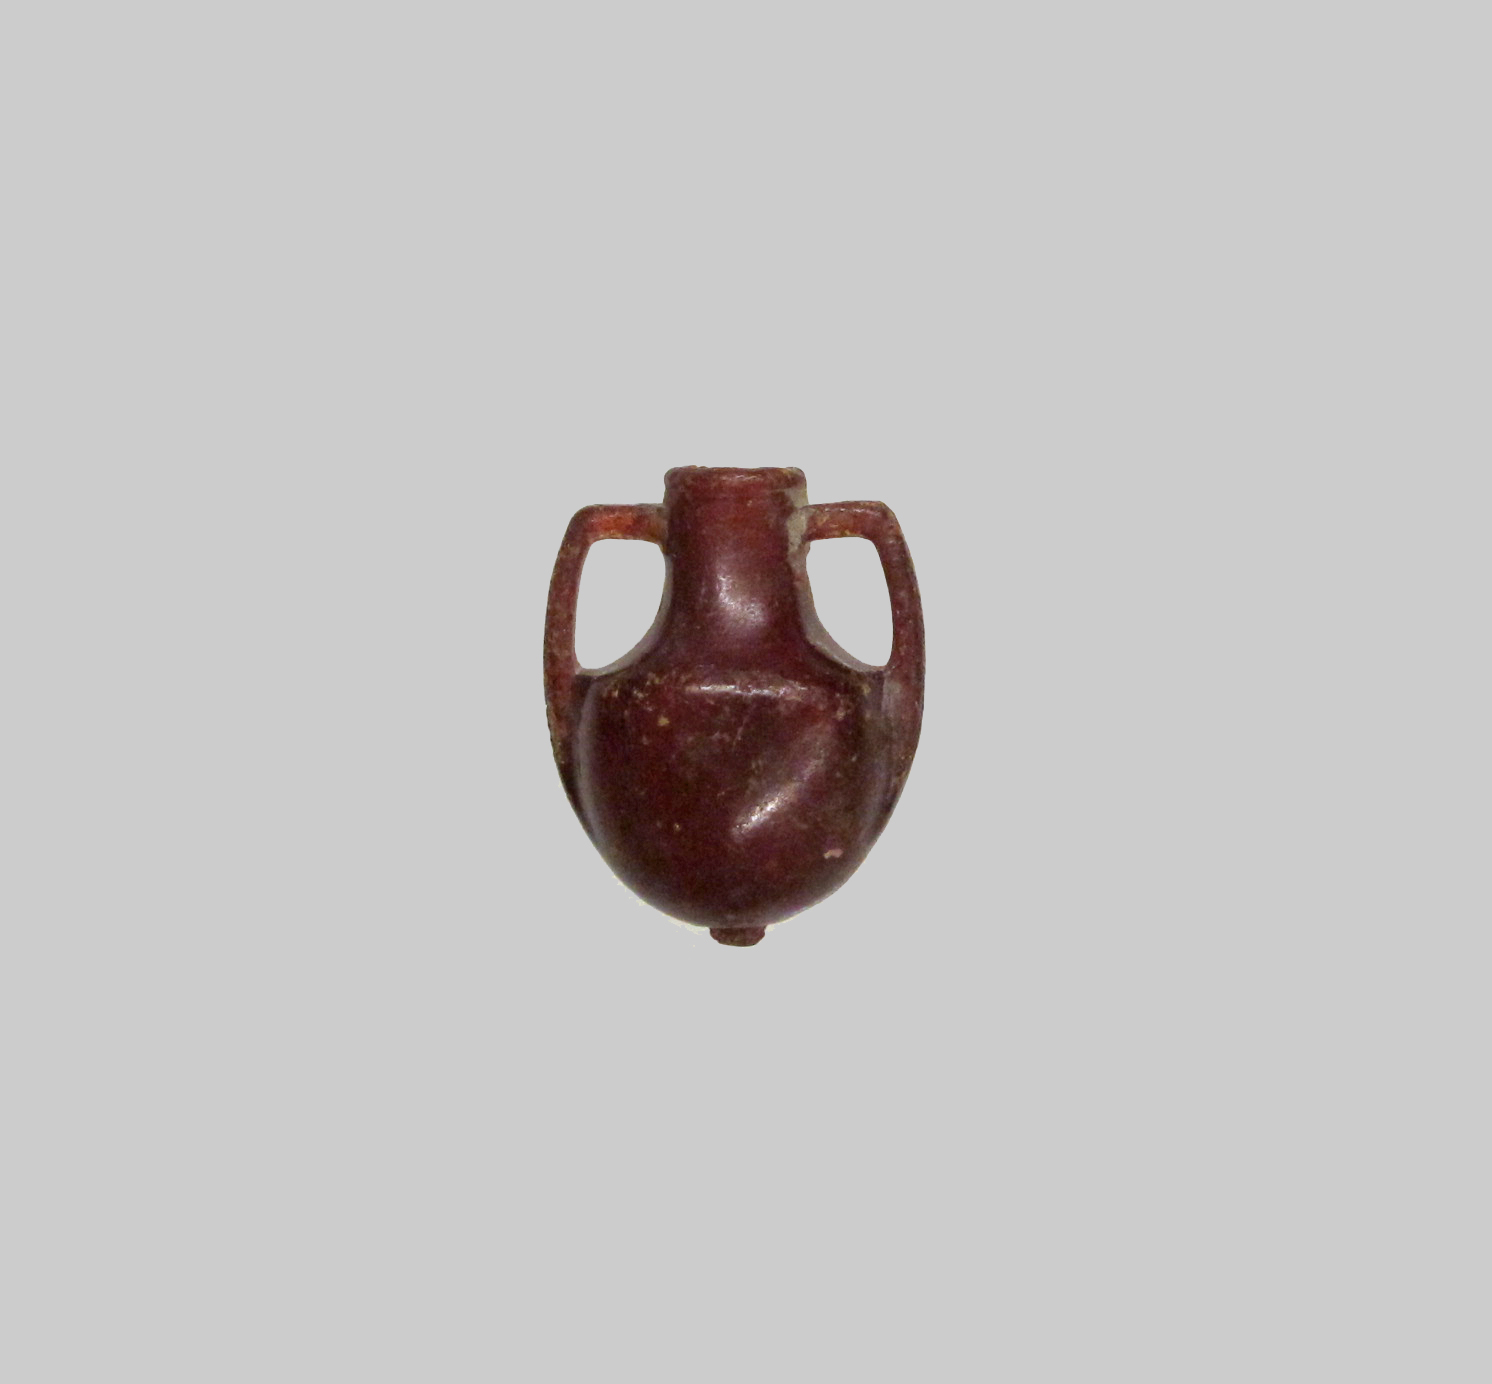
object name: amphora, miniature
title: Miniature amber amphora (jar)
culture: roman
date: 1-100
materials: amber